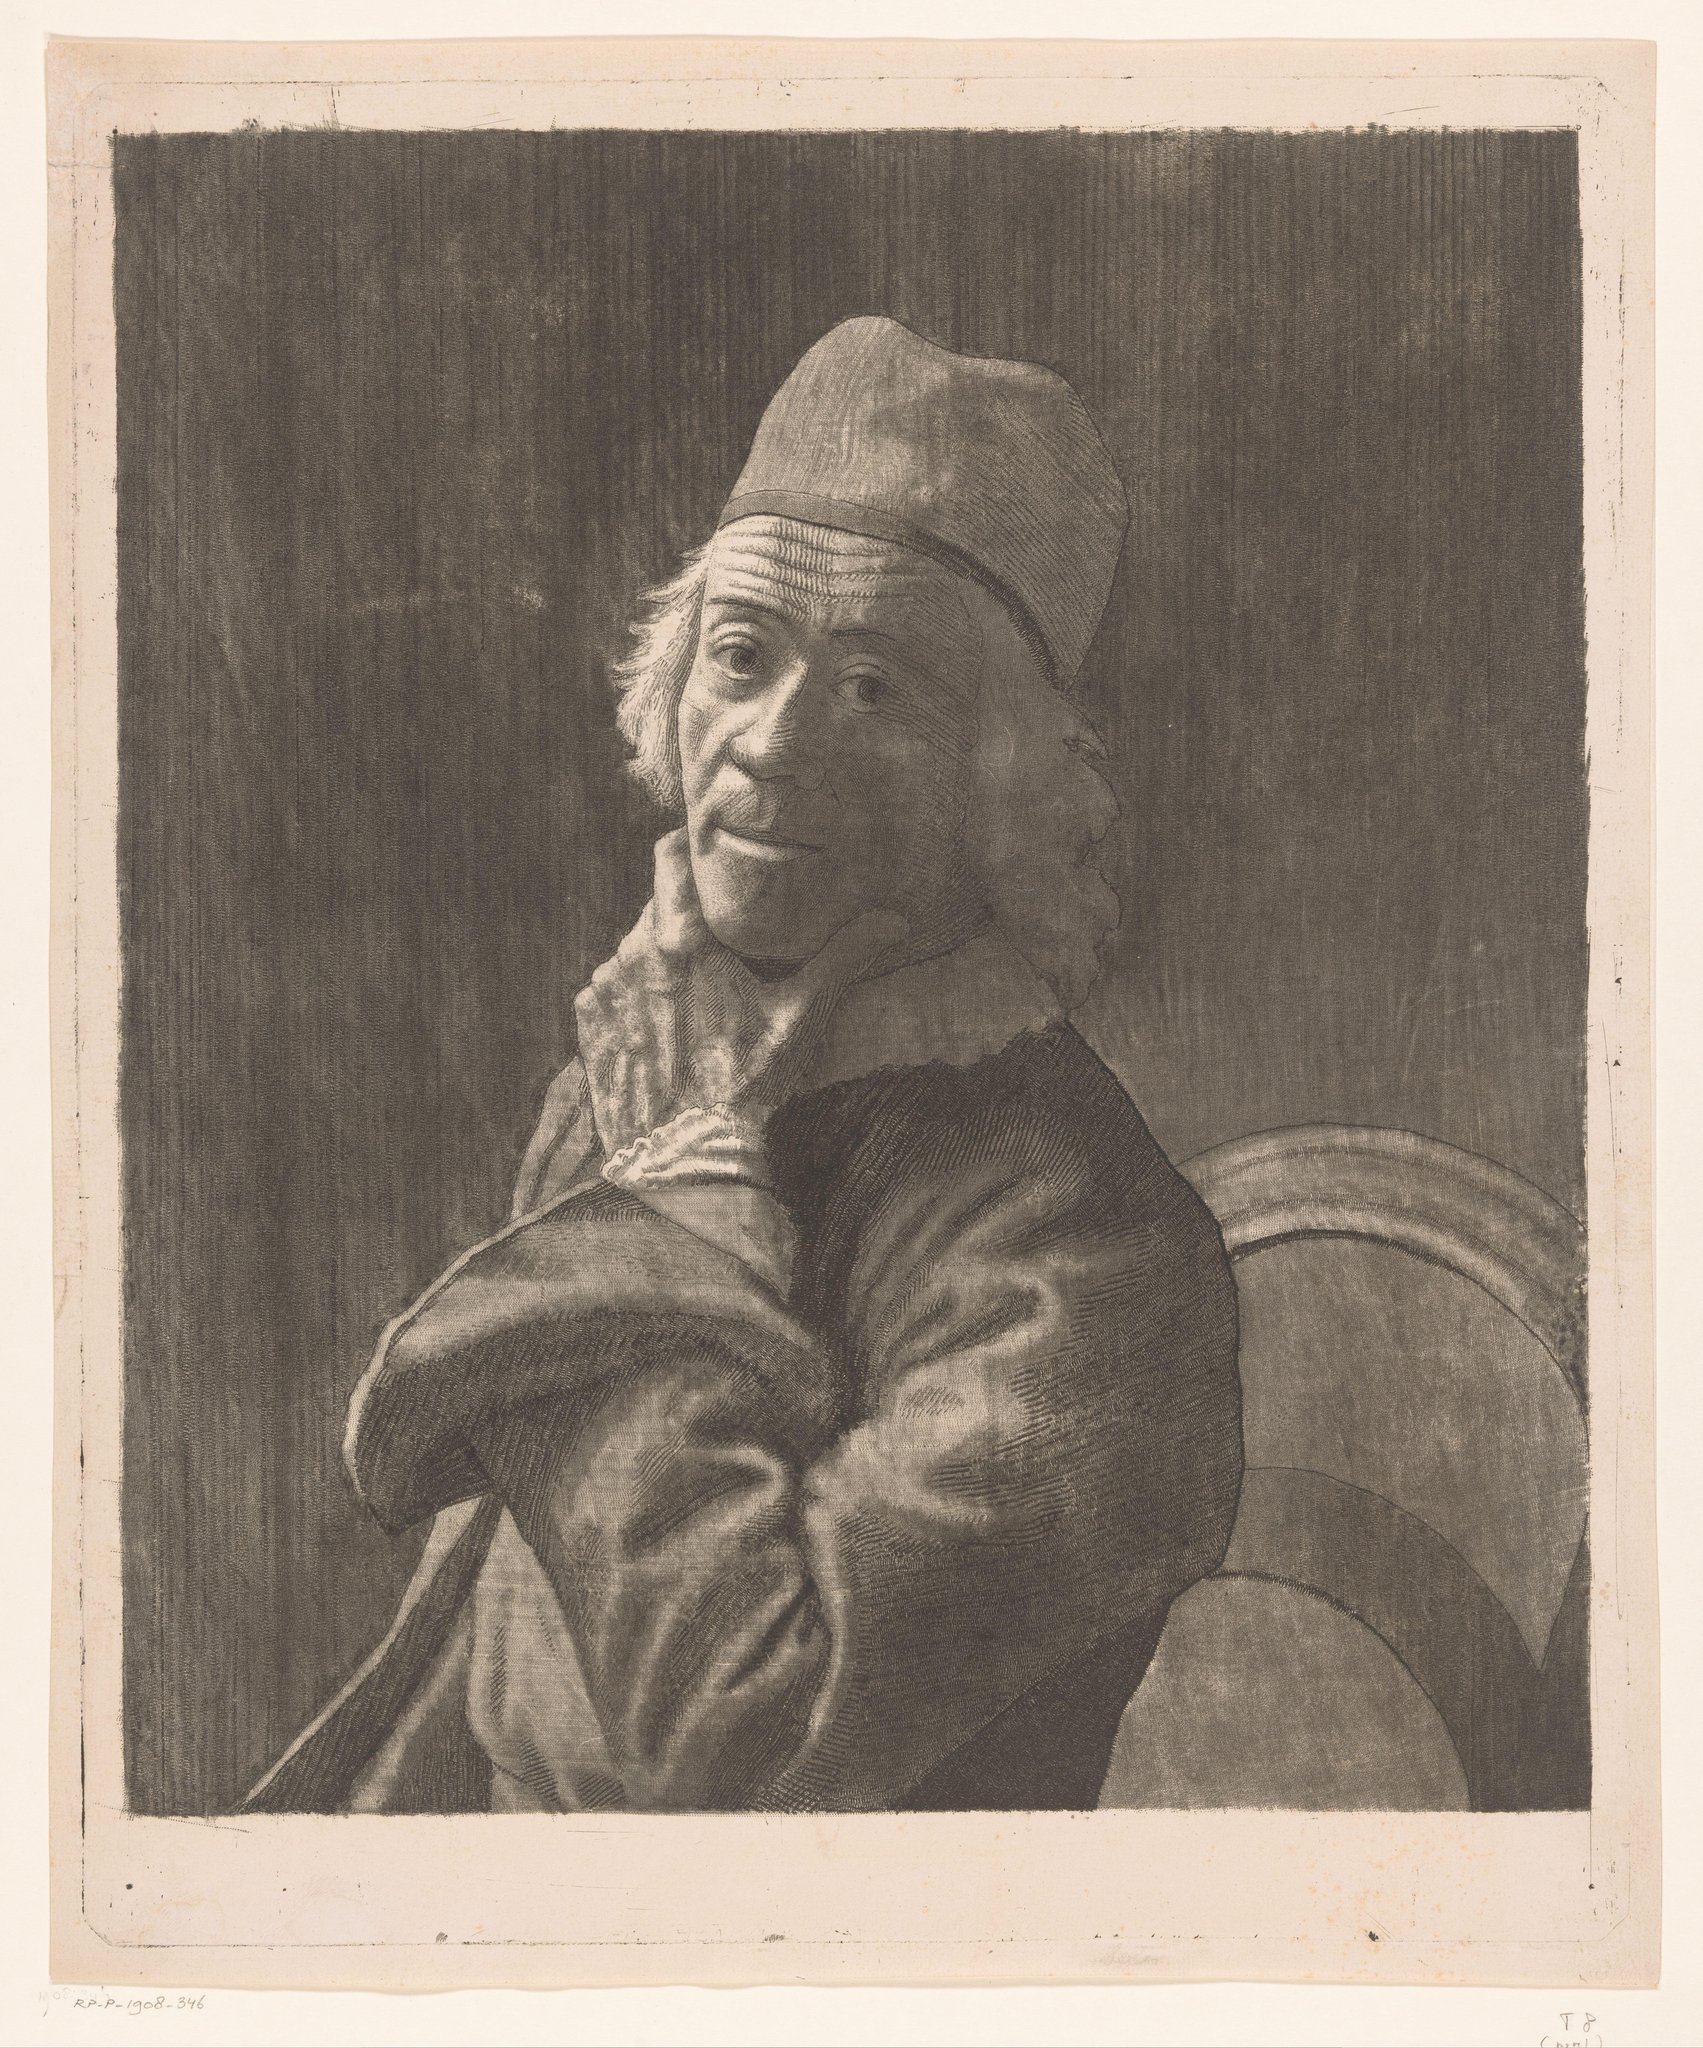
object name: print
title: Portret van Jean-Etienne Liotard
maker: jean-etienne liotard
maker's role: painter, print maker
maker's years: 1702-1789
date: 1778-1780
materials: paper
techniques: etching, roulette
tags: painter, jean-etienne liotard, historical persons, portrait, self-portrait of graphic artist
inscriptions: collector's mark: Lugt 2228